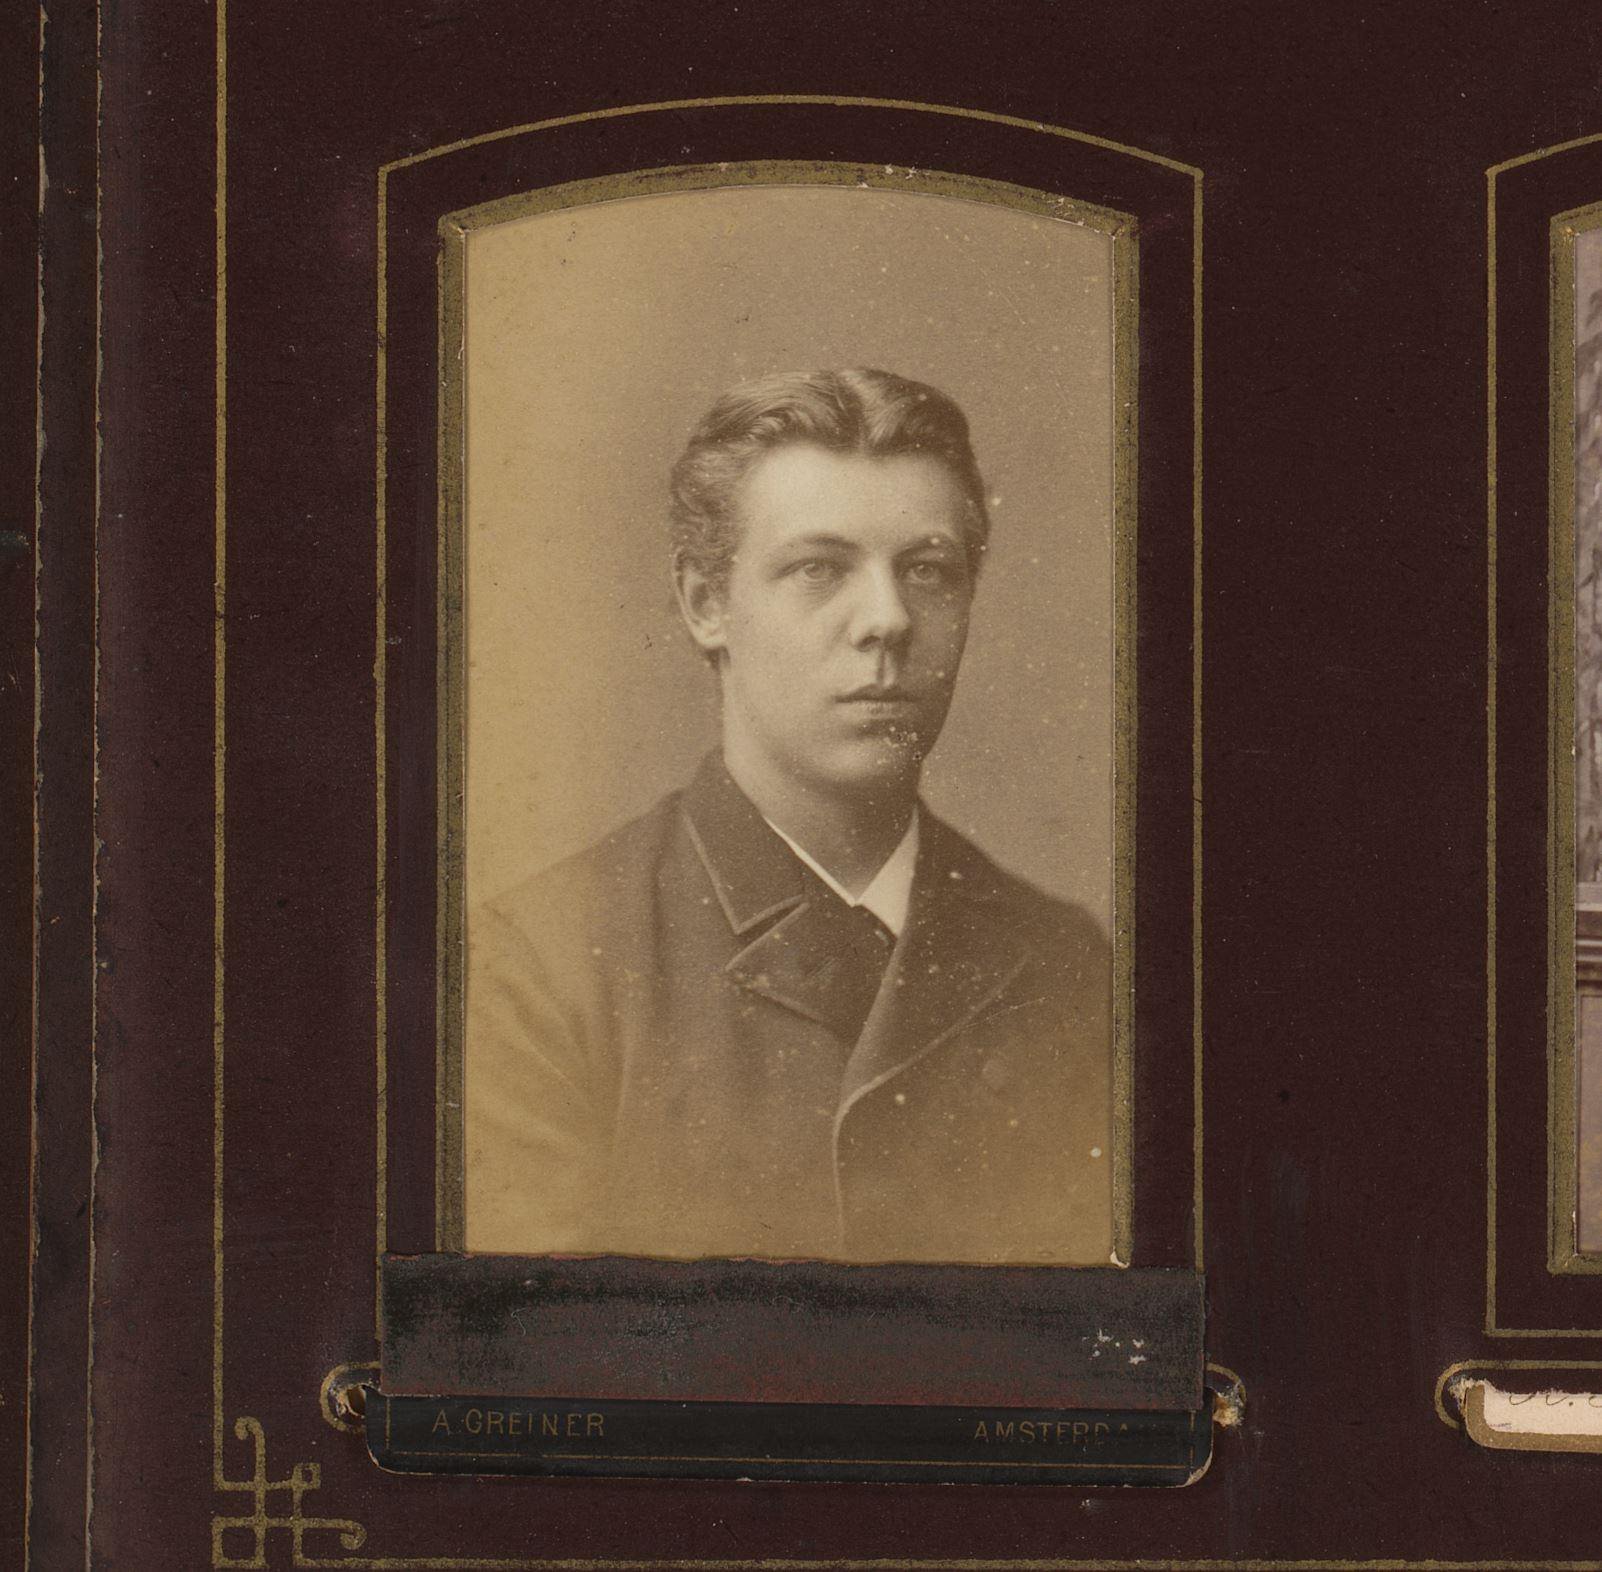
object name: album leaf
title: Portret van een jonge man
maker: albert greiner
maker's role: fotograaf, fotostudio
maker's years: 1833-1890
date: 1861-1890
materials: cardboard, photographic support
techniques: albumen print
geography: amsterdam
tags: historical persons, youth, adolescent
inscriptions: inscription: ‘A. Greiner - Amsterdam’